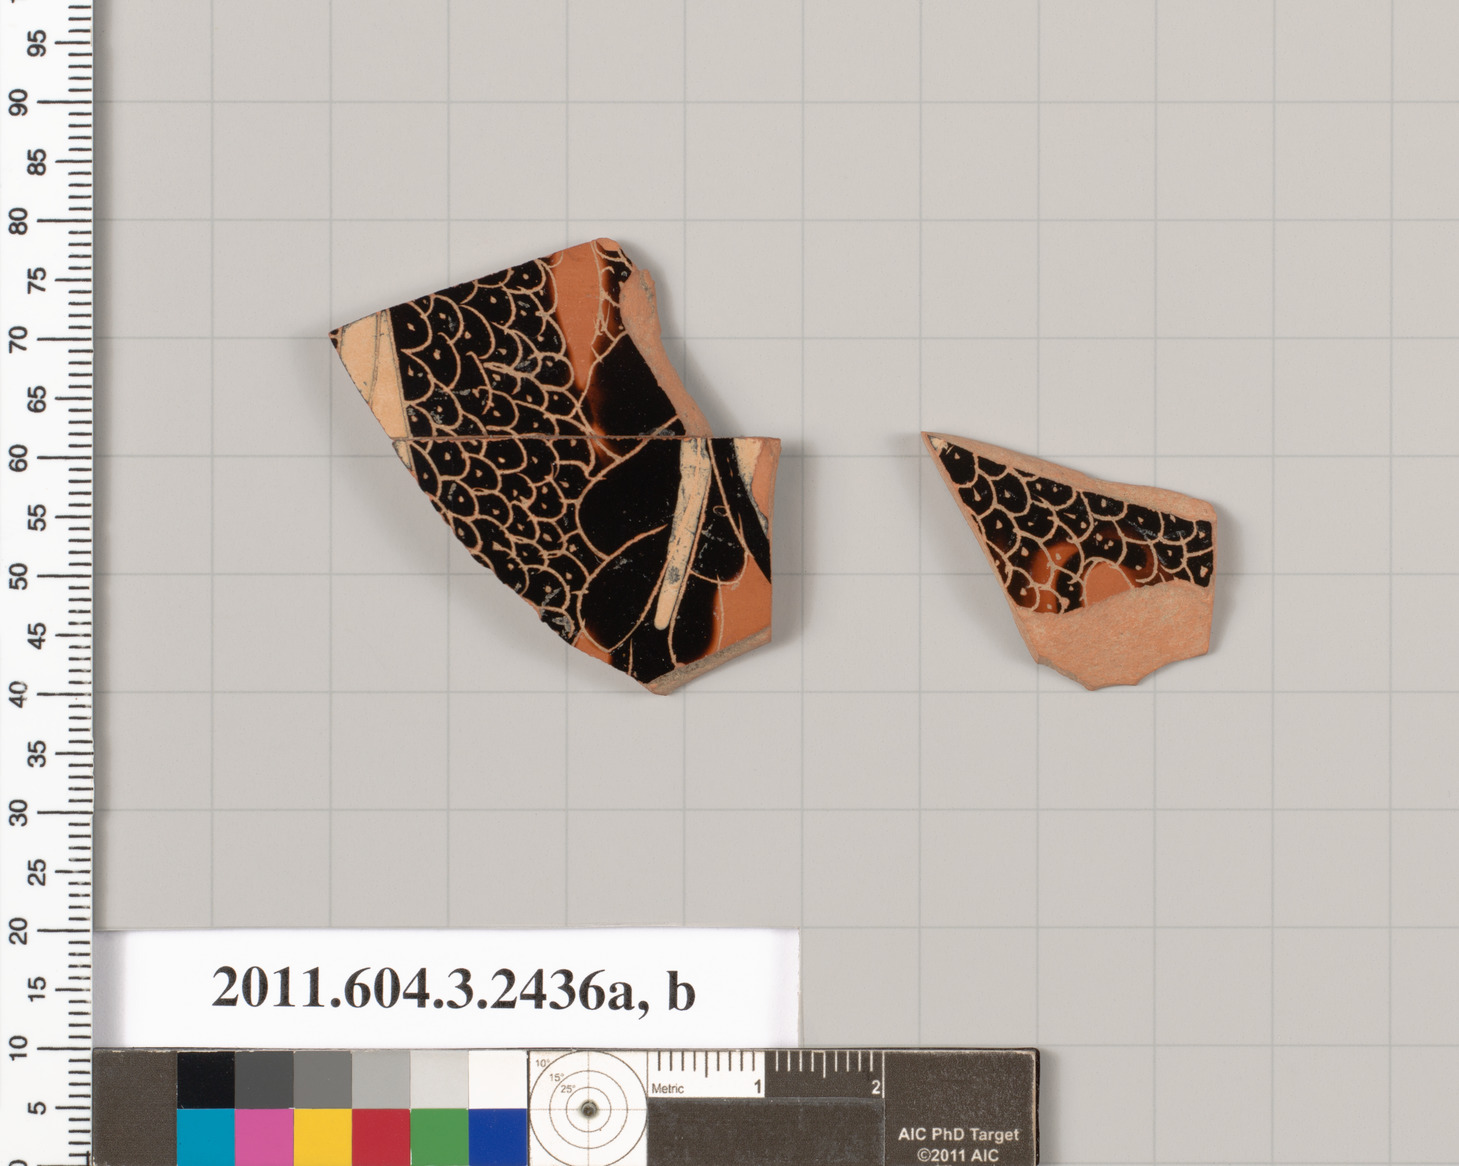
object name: kylix fragment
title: Terracotta fragments of a kylix (drinking cup)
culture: greek, attic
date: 550-501 BCE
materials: terracotta